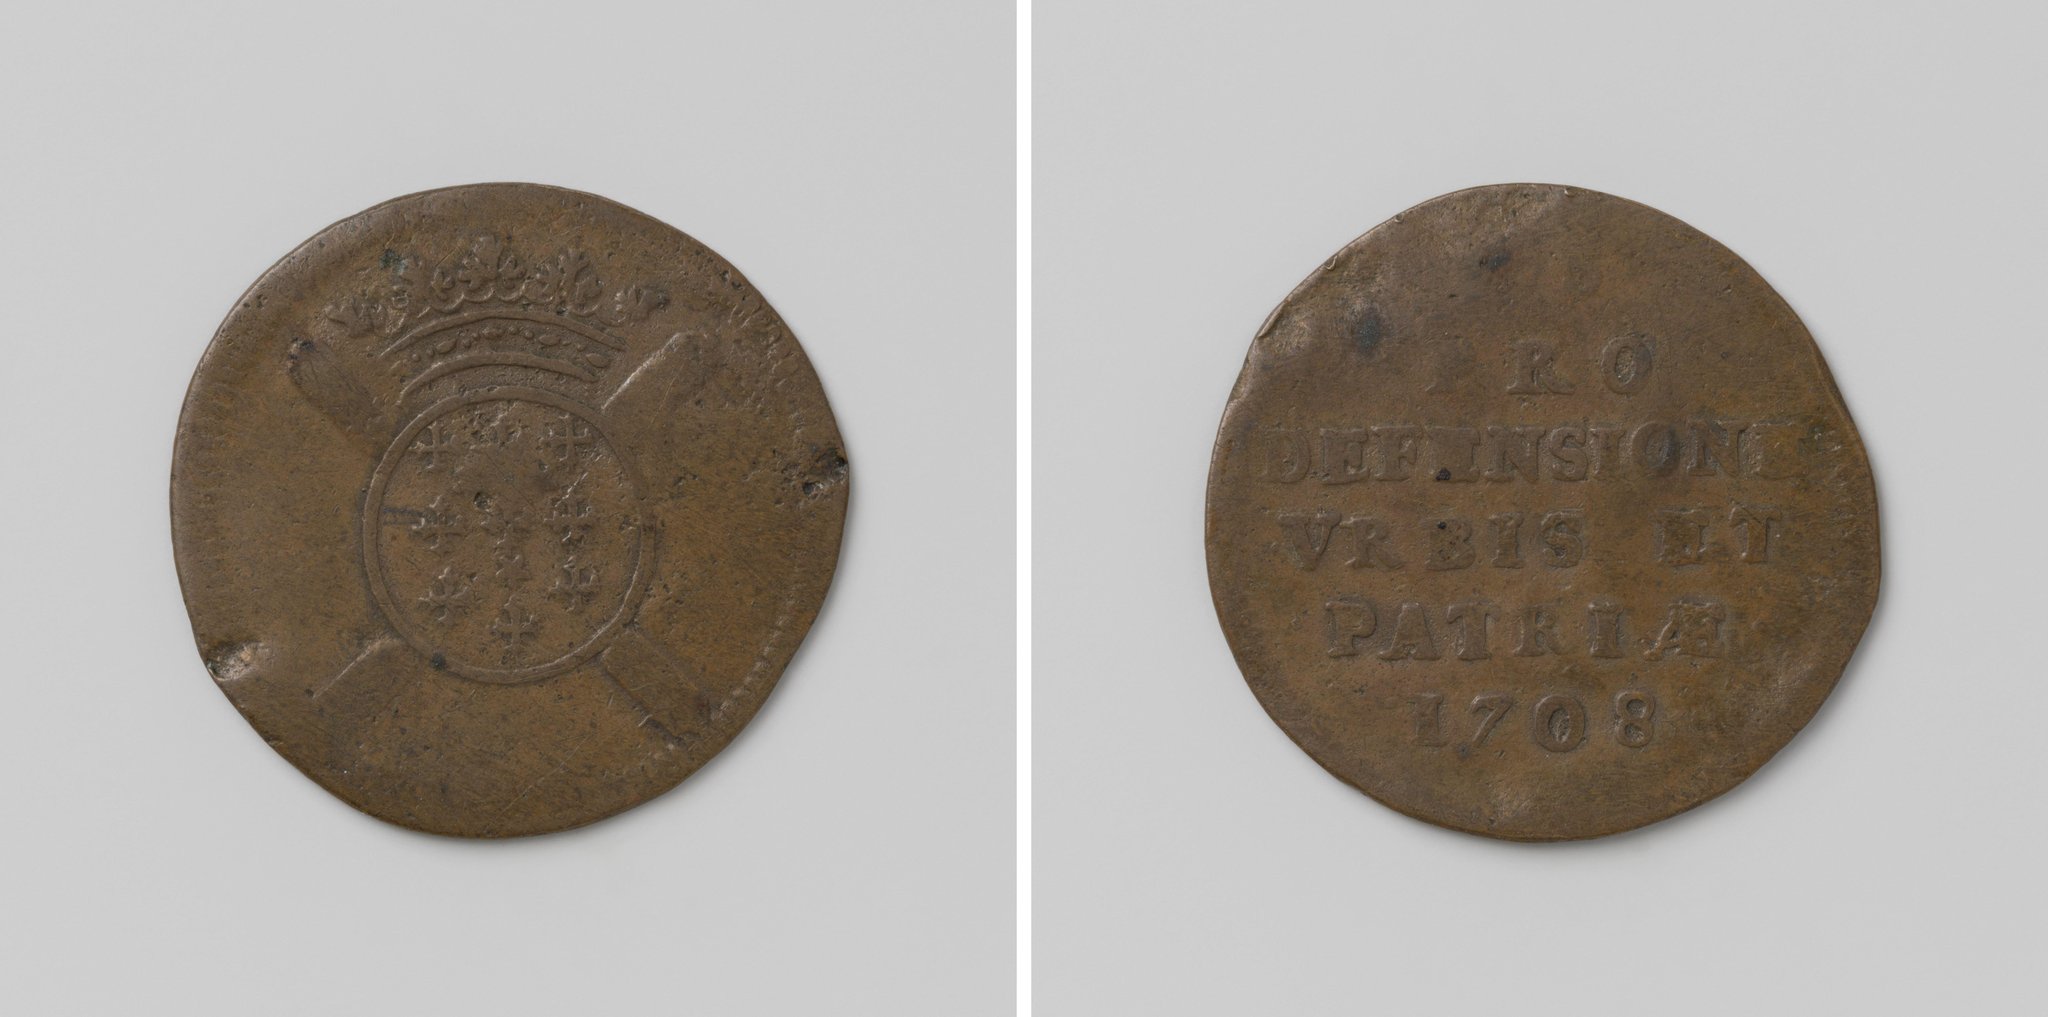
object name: siege coin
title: vijf stuiver, noodmunt van Rijssel, door de bondgenoten ingenomen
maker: Anonymous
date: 1708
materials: copper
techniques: striking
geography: lille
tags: lille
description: Voorzijde: gekroond wapenschild op twee gekruiste maarschalkstaven. Keerzijde: opschrift